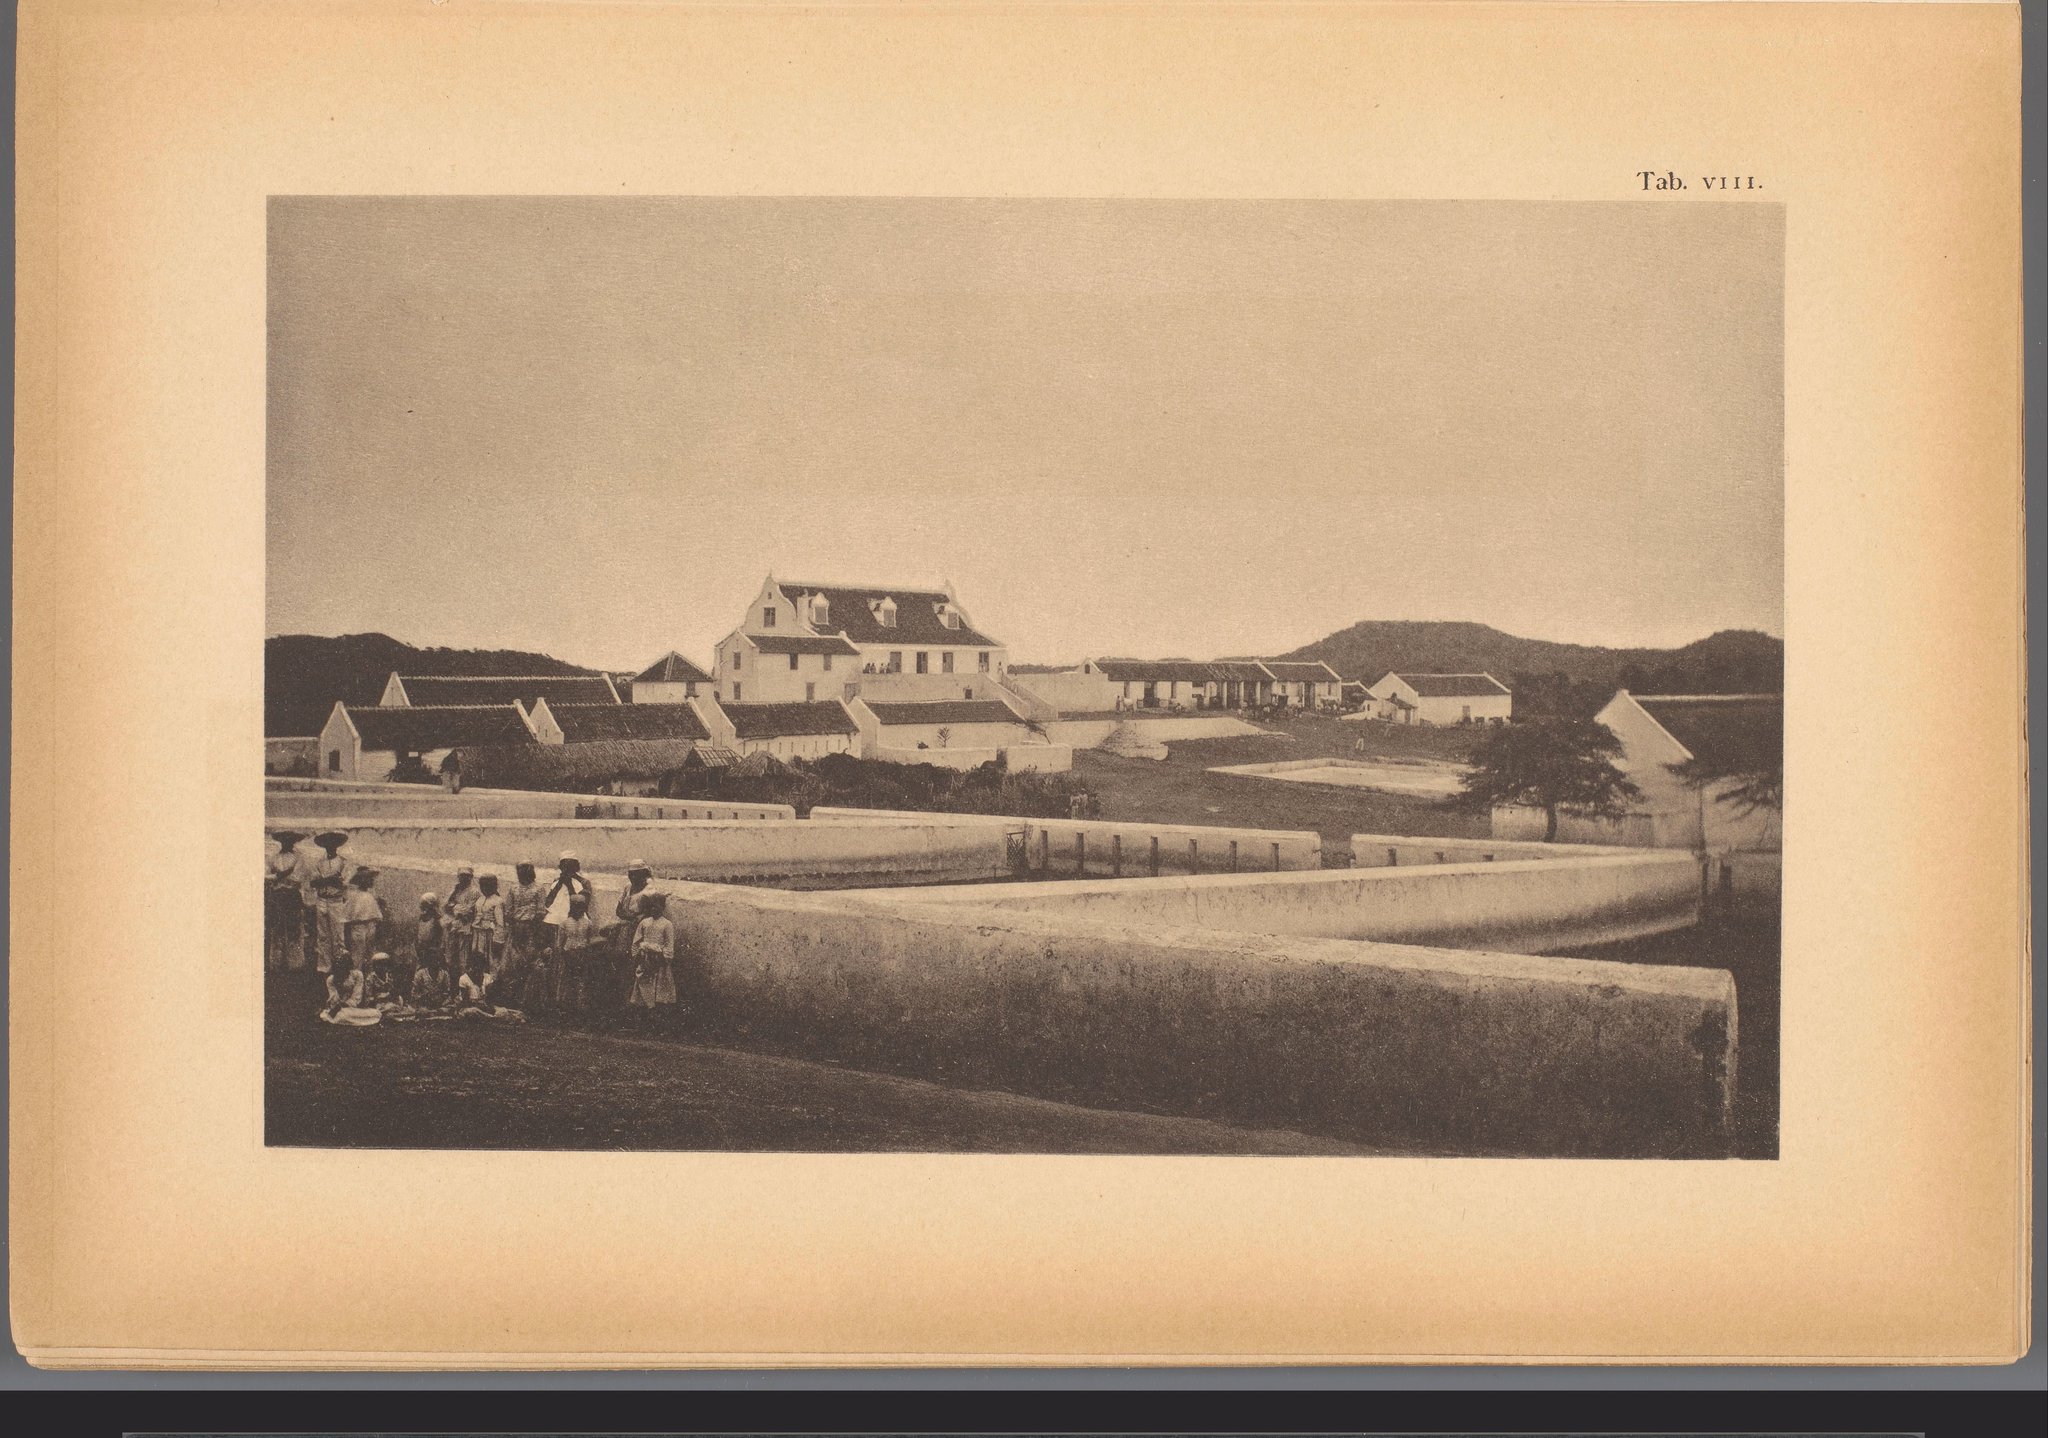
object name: photomechanical print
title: Gezicht op plantage Savonet op Curaçao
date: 1877-1887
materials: paper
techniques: photograph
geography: curacao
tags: plantation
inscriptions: number: ‘Tab. VIII.’